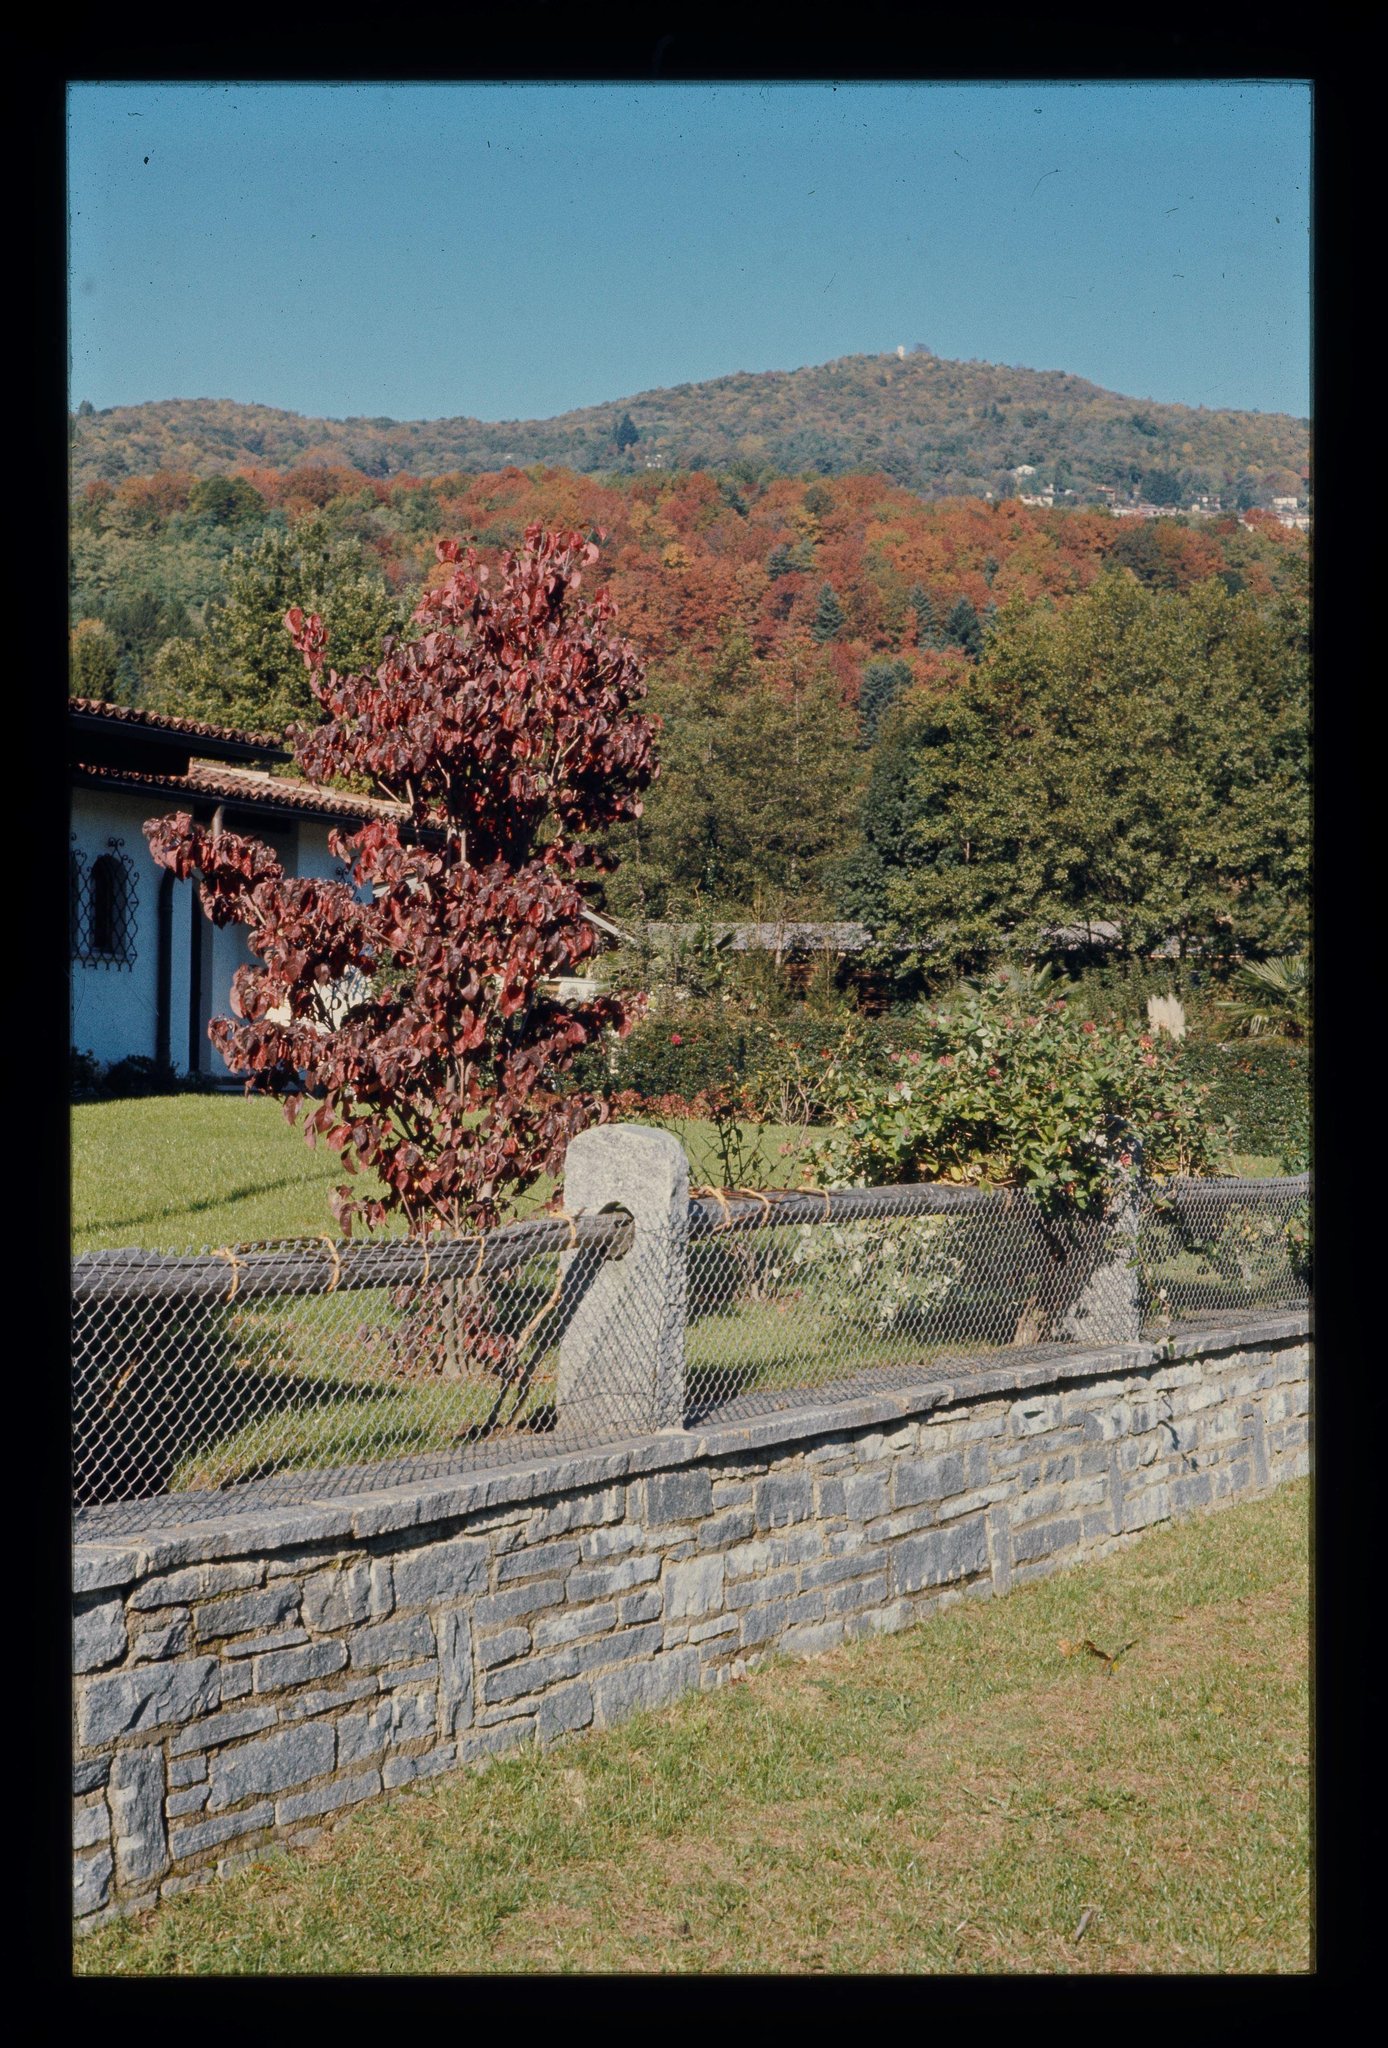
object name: photograph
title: Berglandschap met op de voorgrond een huis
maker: Anonymous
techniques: slide